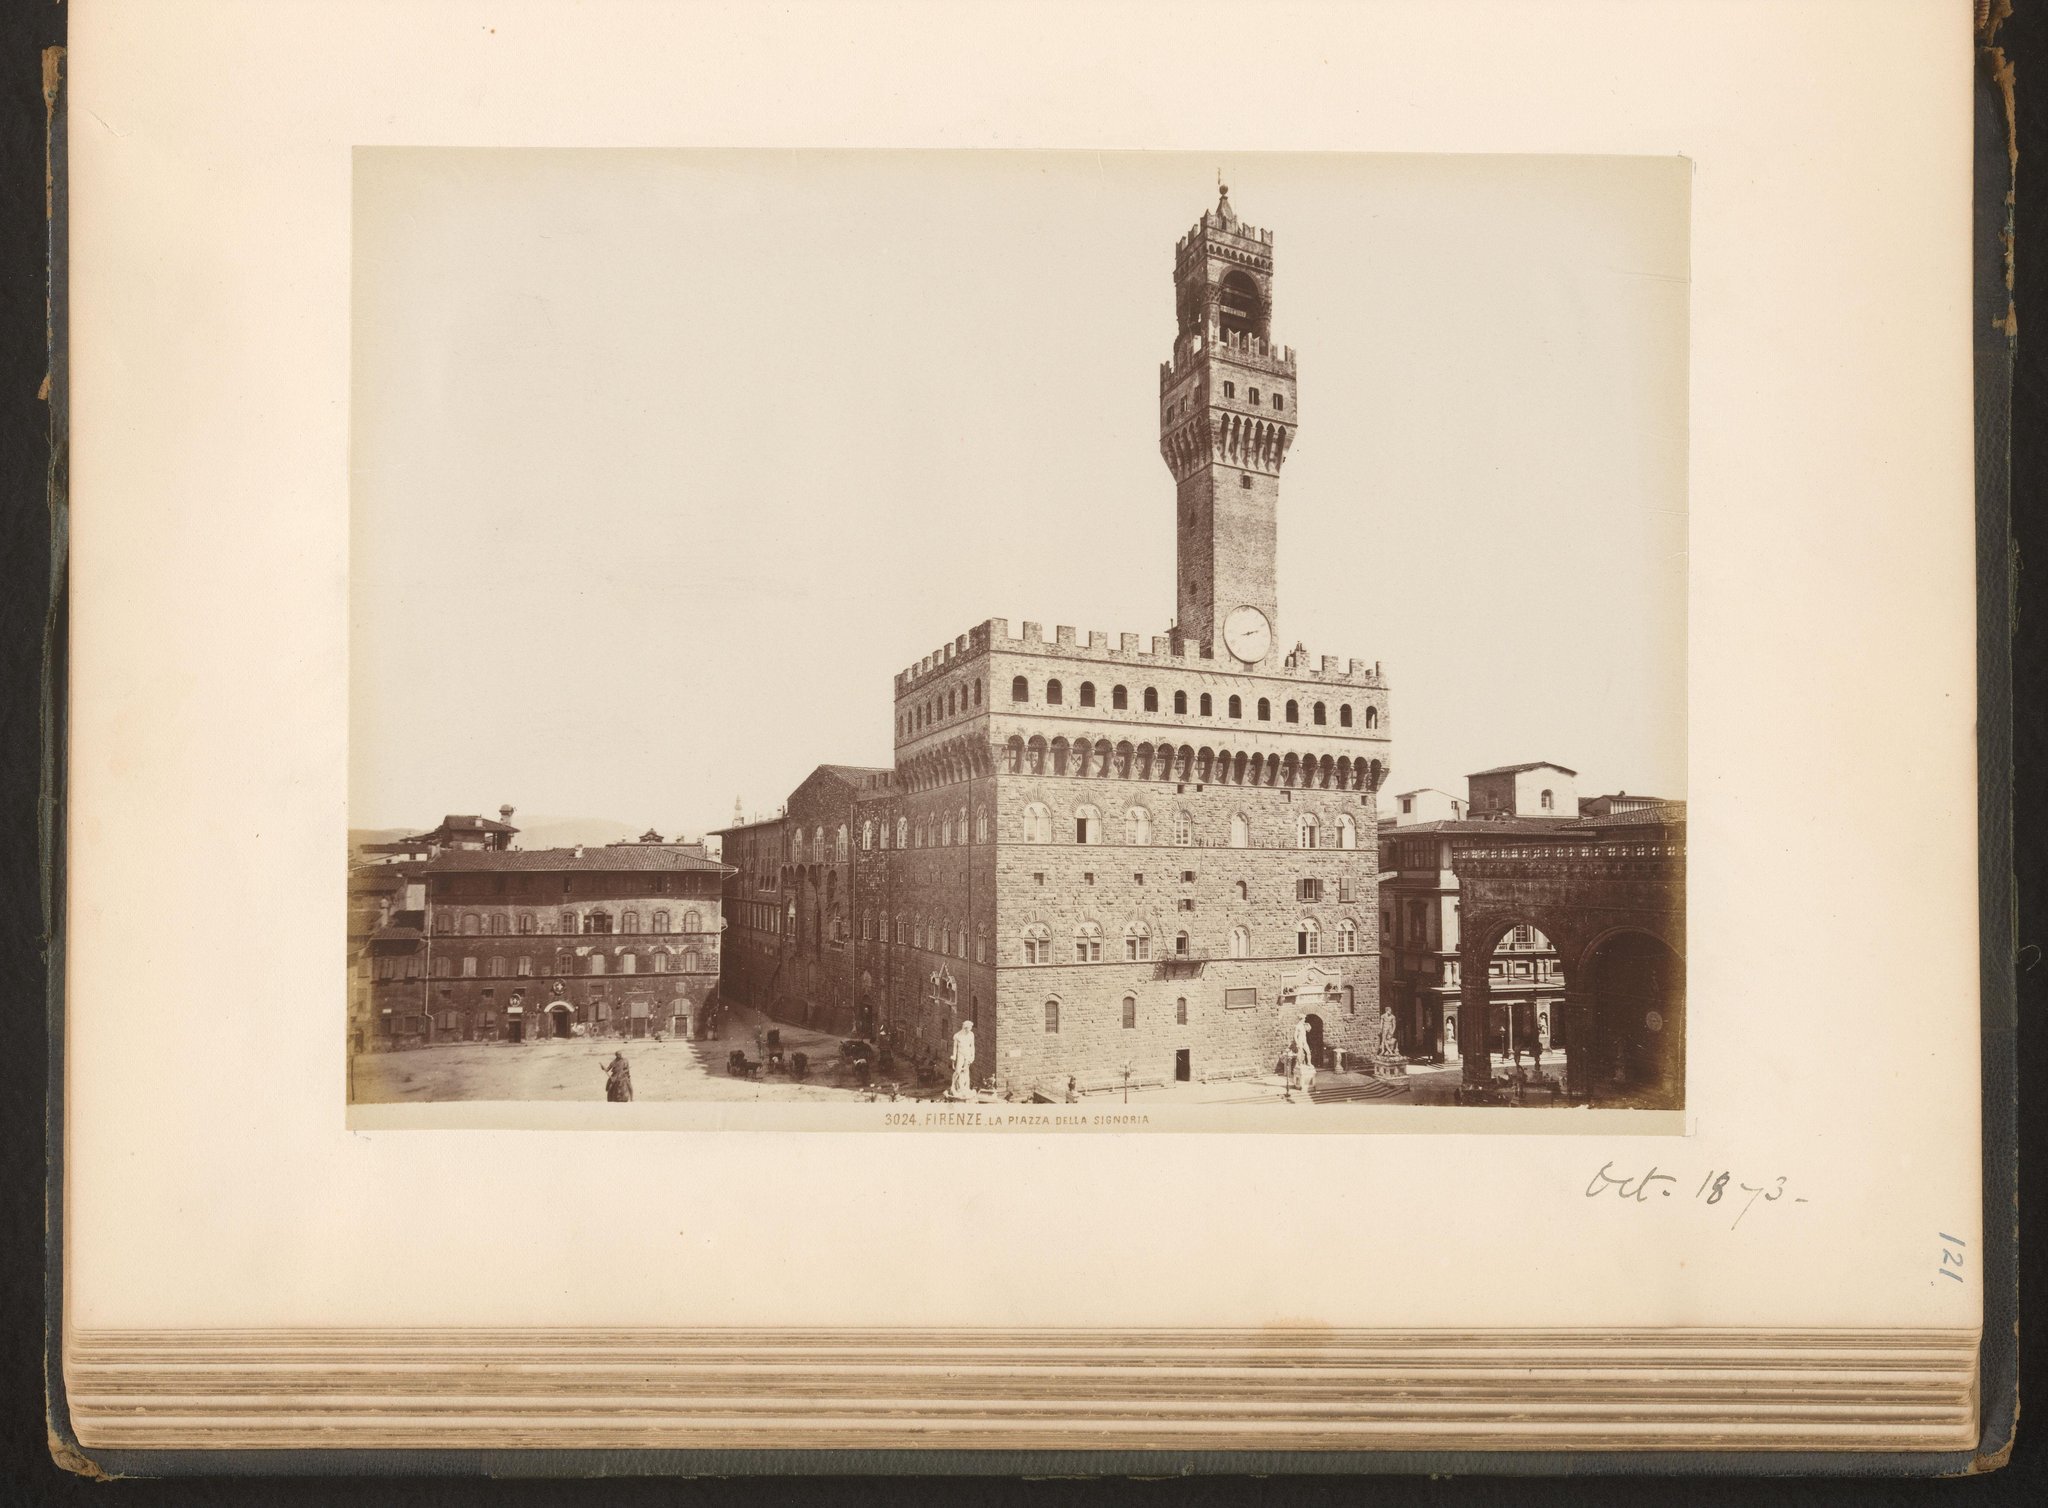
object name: photograph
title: Palazzo Vecchio aan het Piazza della Signoria te Florence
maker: Anonymous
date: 1810-1873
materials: paper, photographic support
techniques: albumen print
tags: permanent exhibition, museum, front façade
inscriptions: inscription: ‘3024. Firenze la piazza della signoria’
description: Deze pagina maakt deel uit van een album.